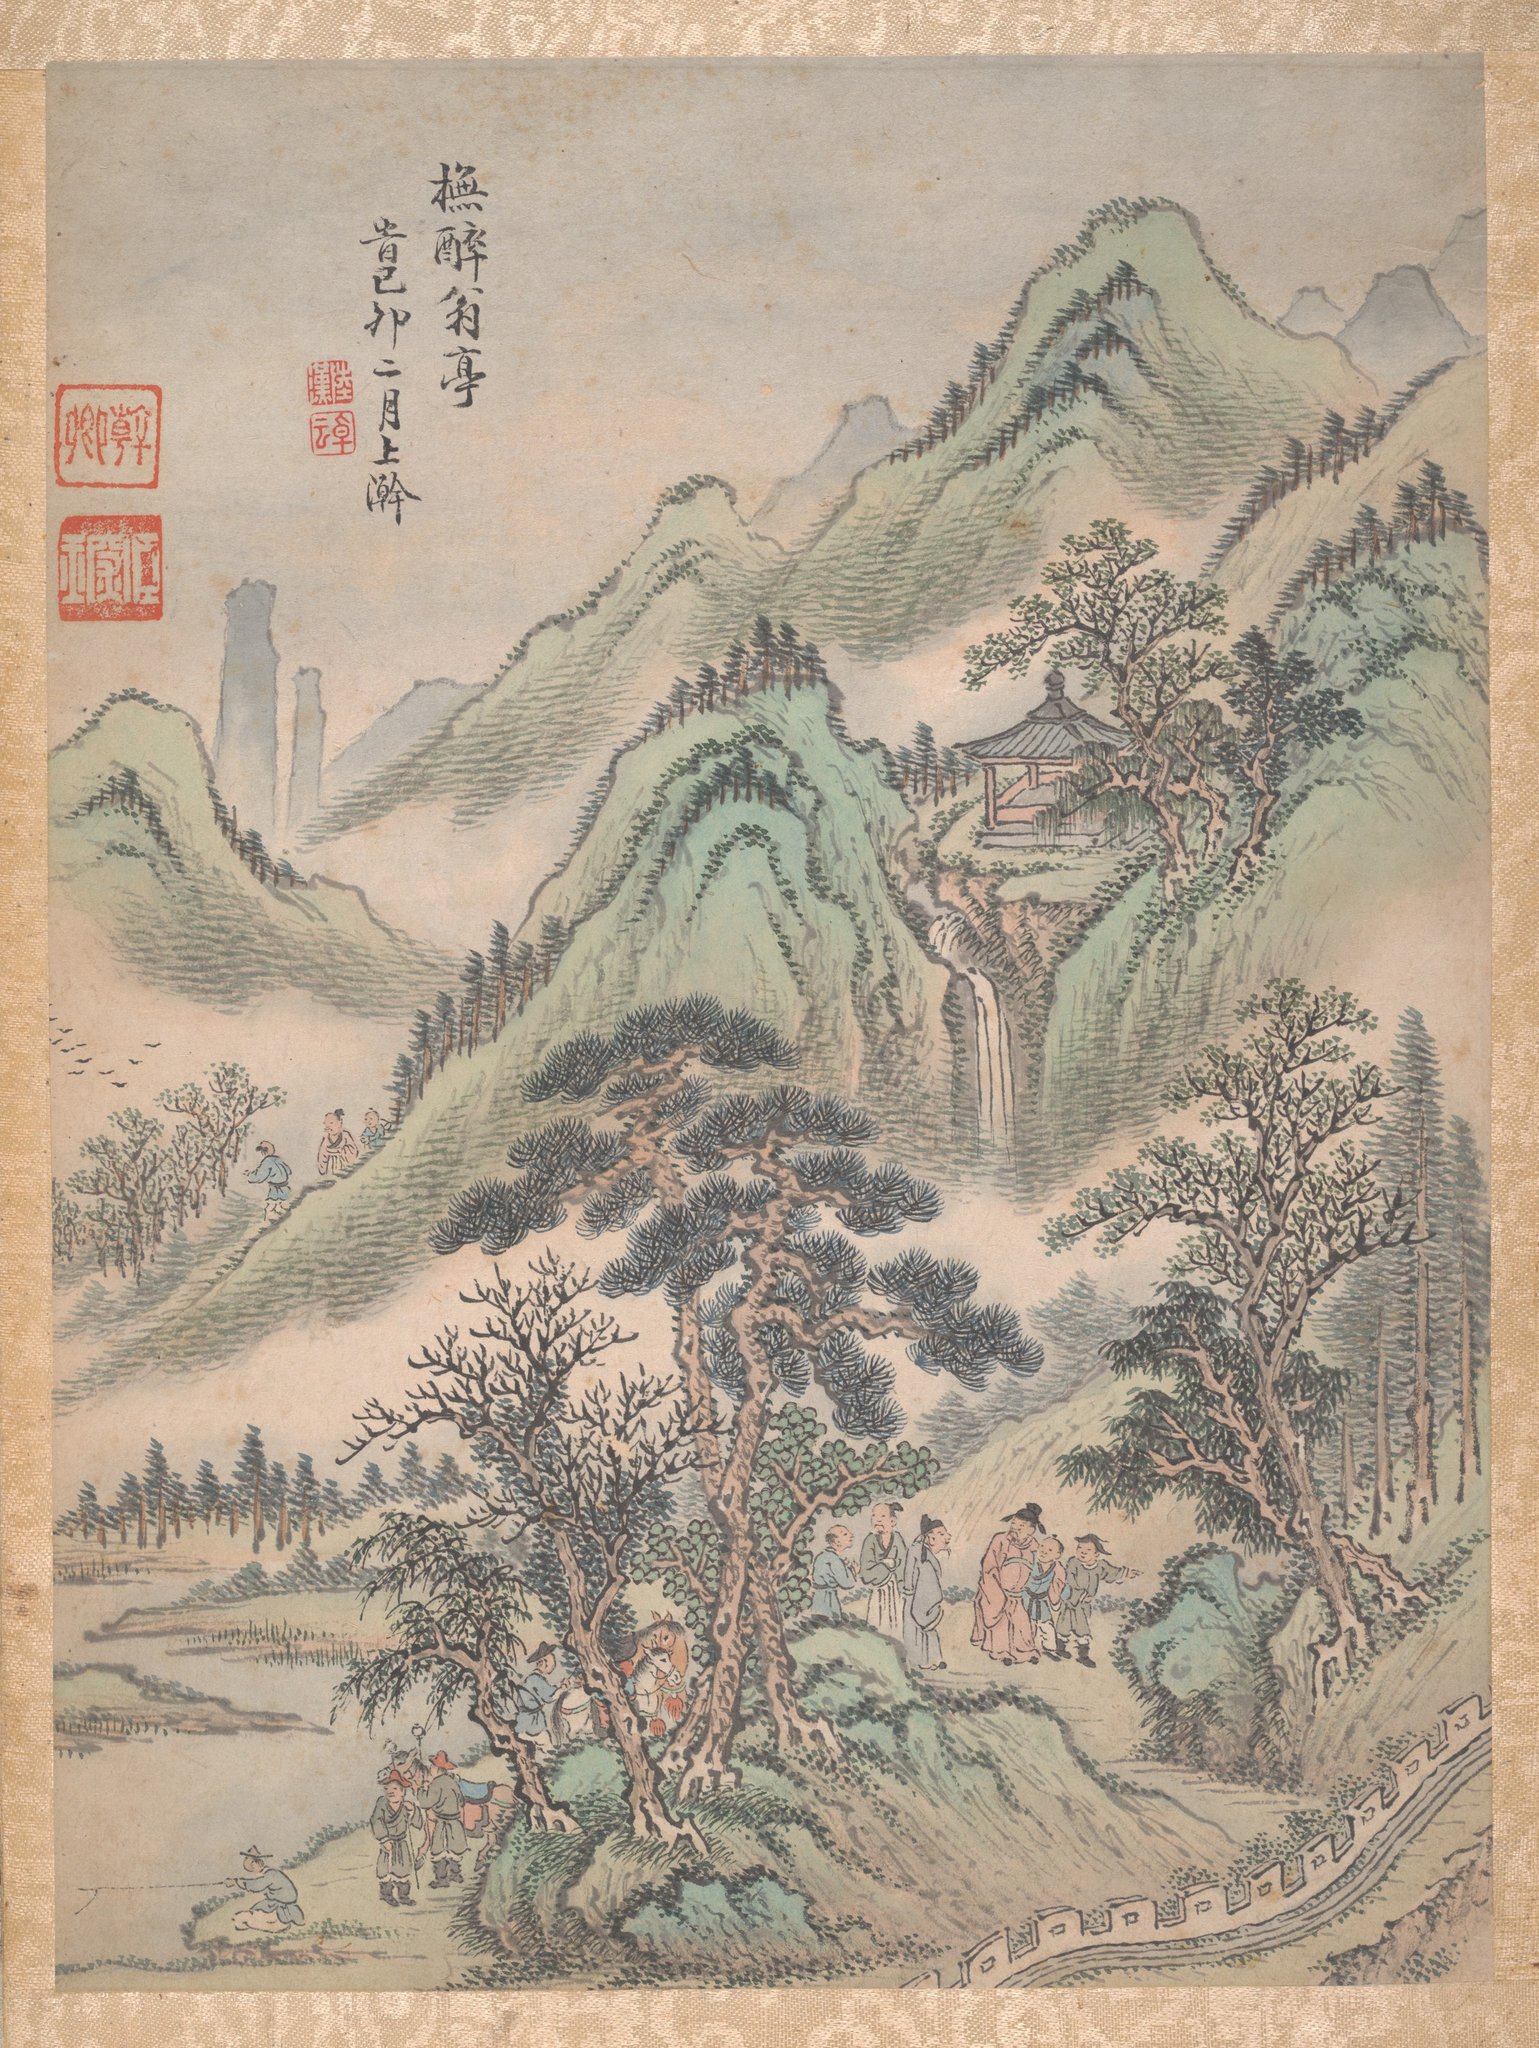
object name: album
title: Eight landscapes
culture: chinese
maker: lu han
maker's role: artist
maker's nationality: chinese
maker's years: -1722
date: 1699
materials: ink, paper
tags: mountains,landscapes